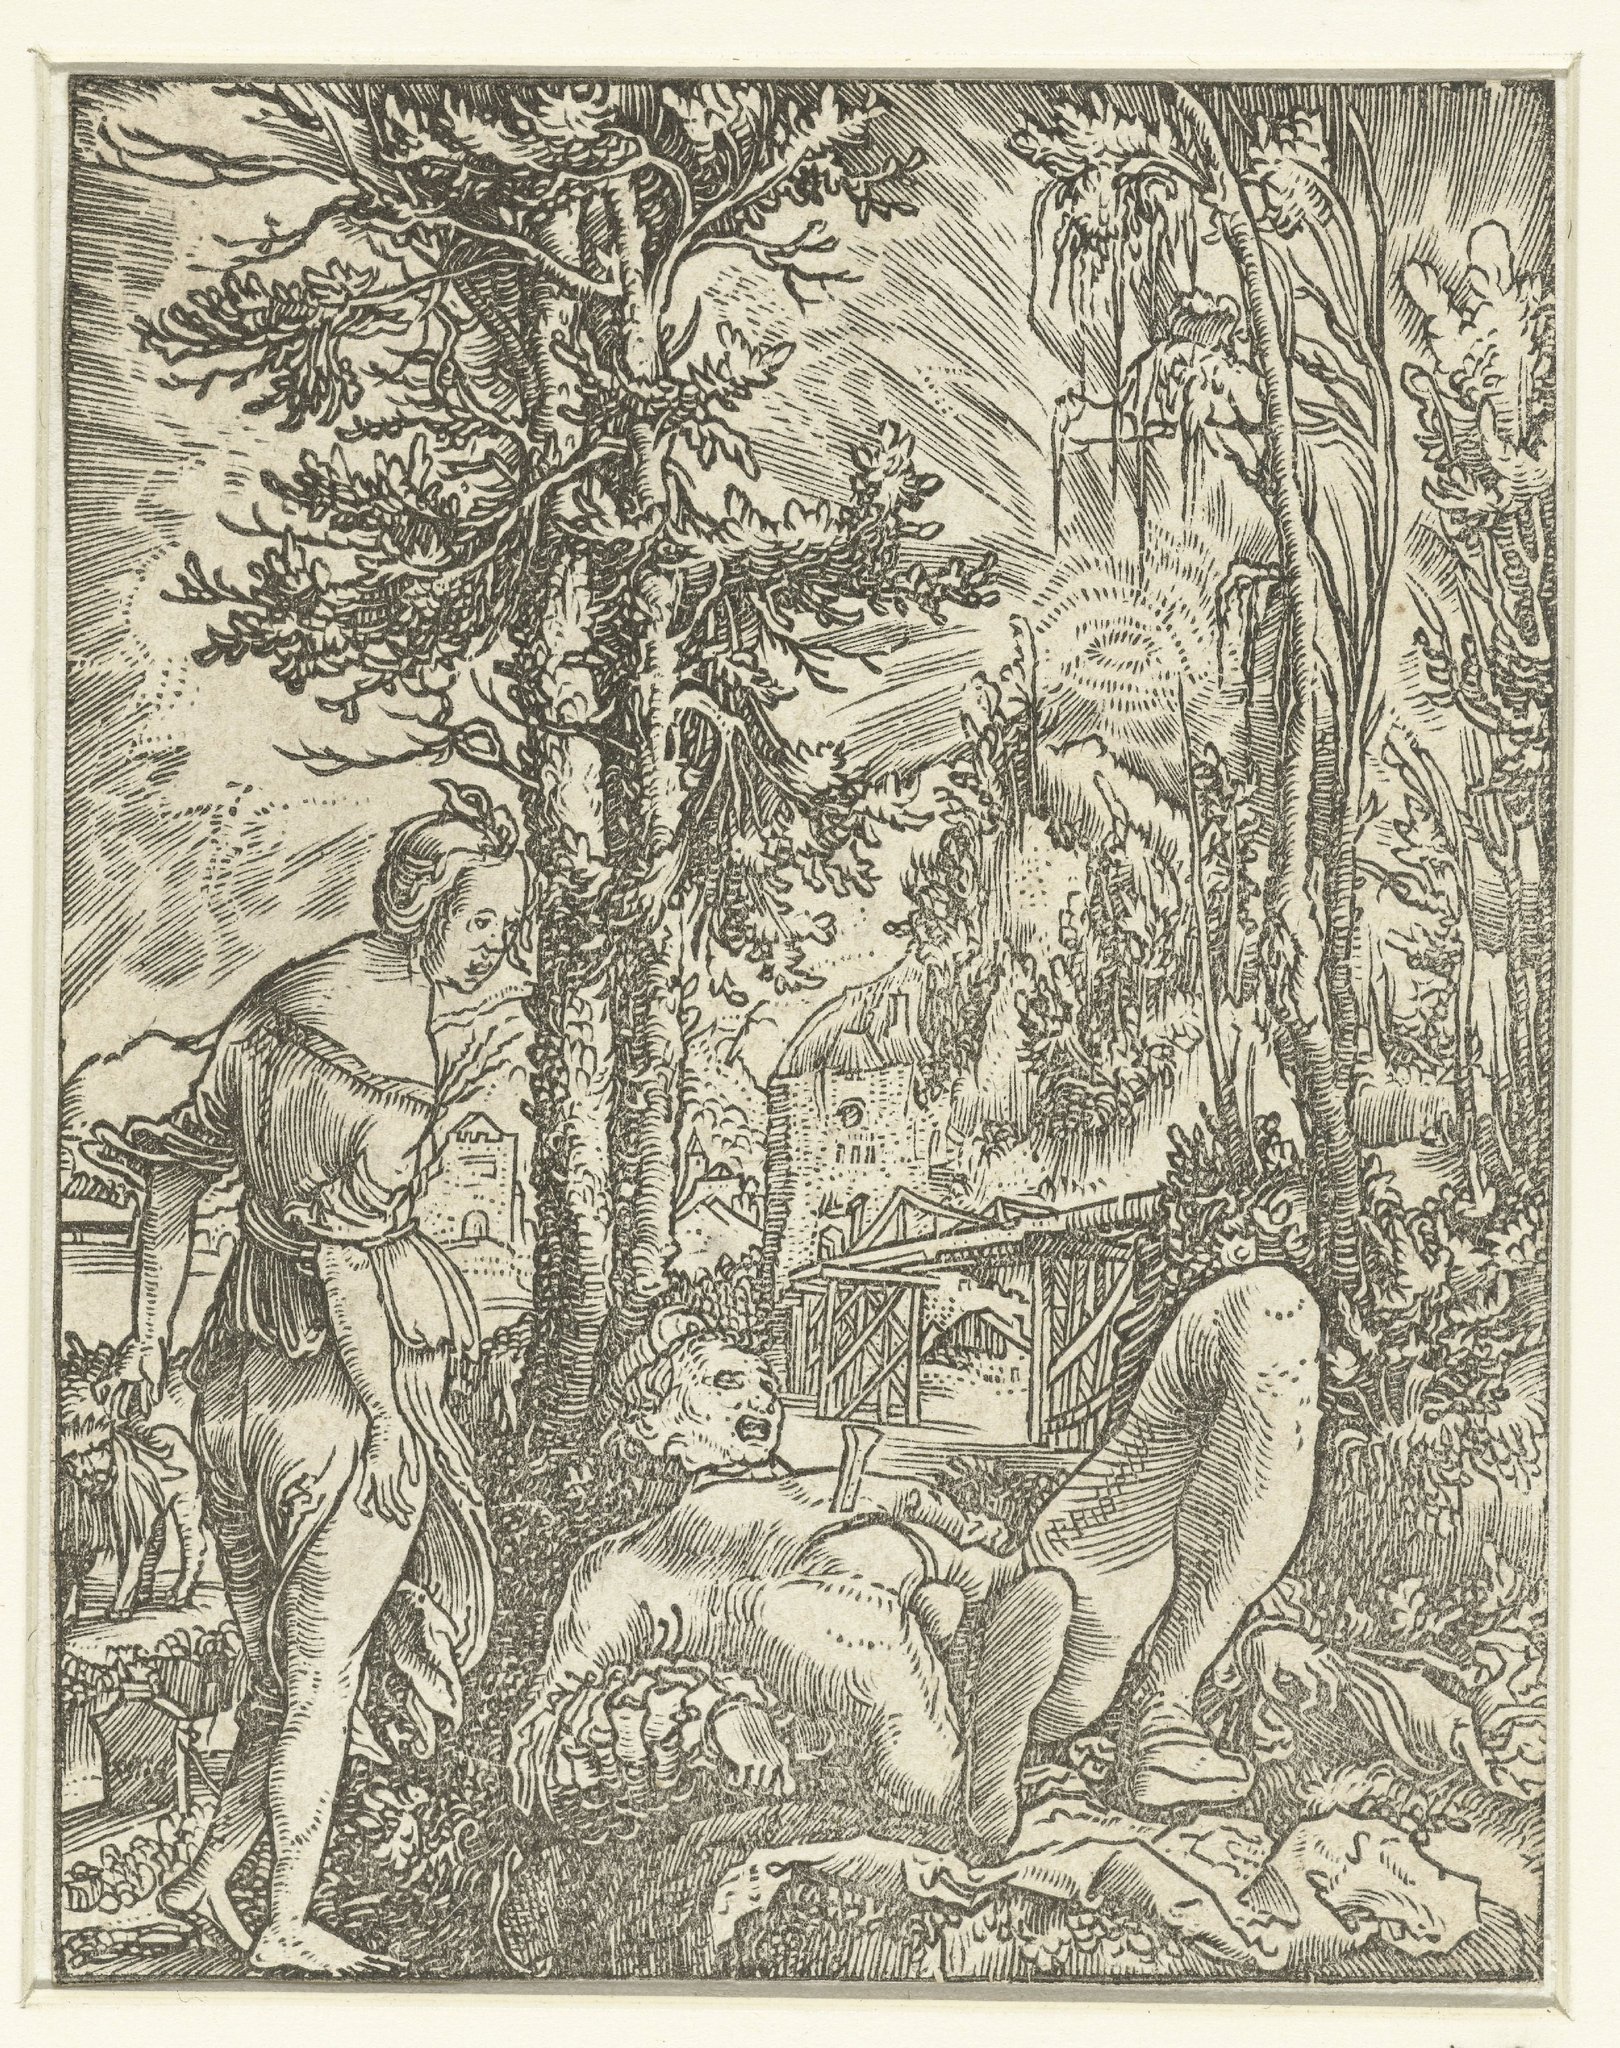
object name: print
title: Pyramus en Thisbe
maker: wolfgang huber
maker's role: draughtsman, print maker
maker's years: 1490-1553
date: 1500-1553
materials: paper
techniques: woodcut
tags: thisbe kills herself with pyramus' sword (the scene may be represented near a fountain)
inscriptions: collector's mark: Lugt 240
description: Thisbe treft haar geliefde Pyramus stervend aan. Hij ligt op de grond bij twee bomen met een mes in zijn borst gestoken terwijl zij geschrokken naast hem staat. Links staat de leeuwin die in het verhaal de sluier van Thisbe aan stukken scheurt, deze sluier ligt op de grond. Tussen de bomen is een stad zichtbaar.